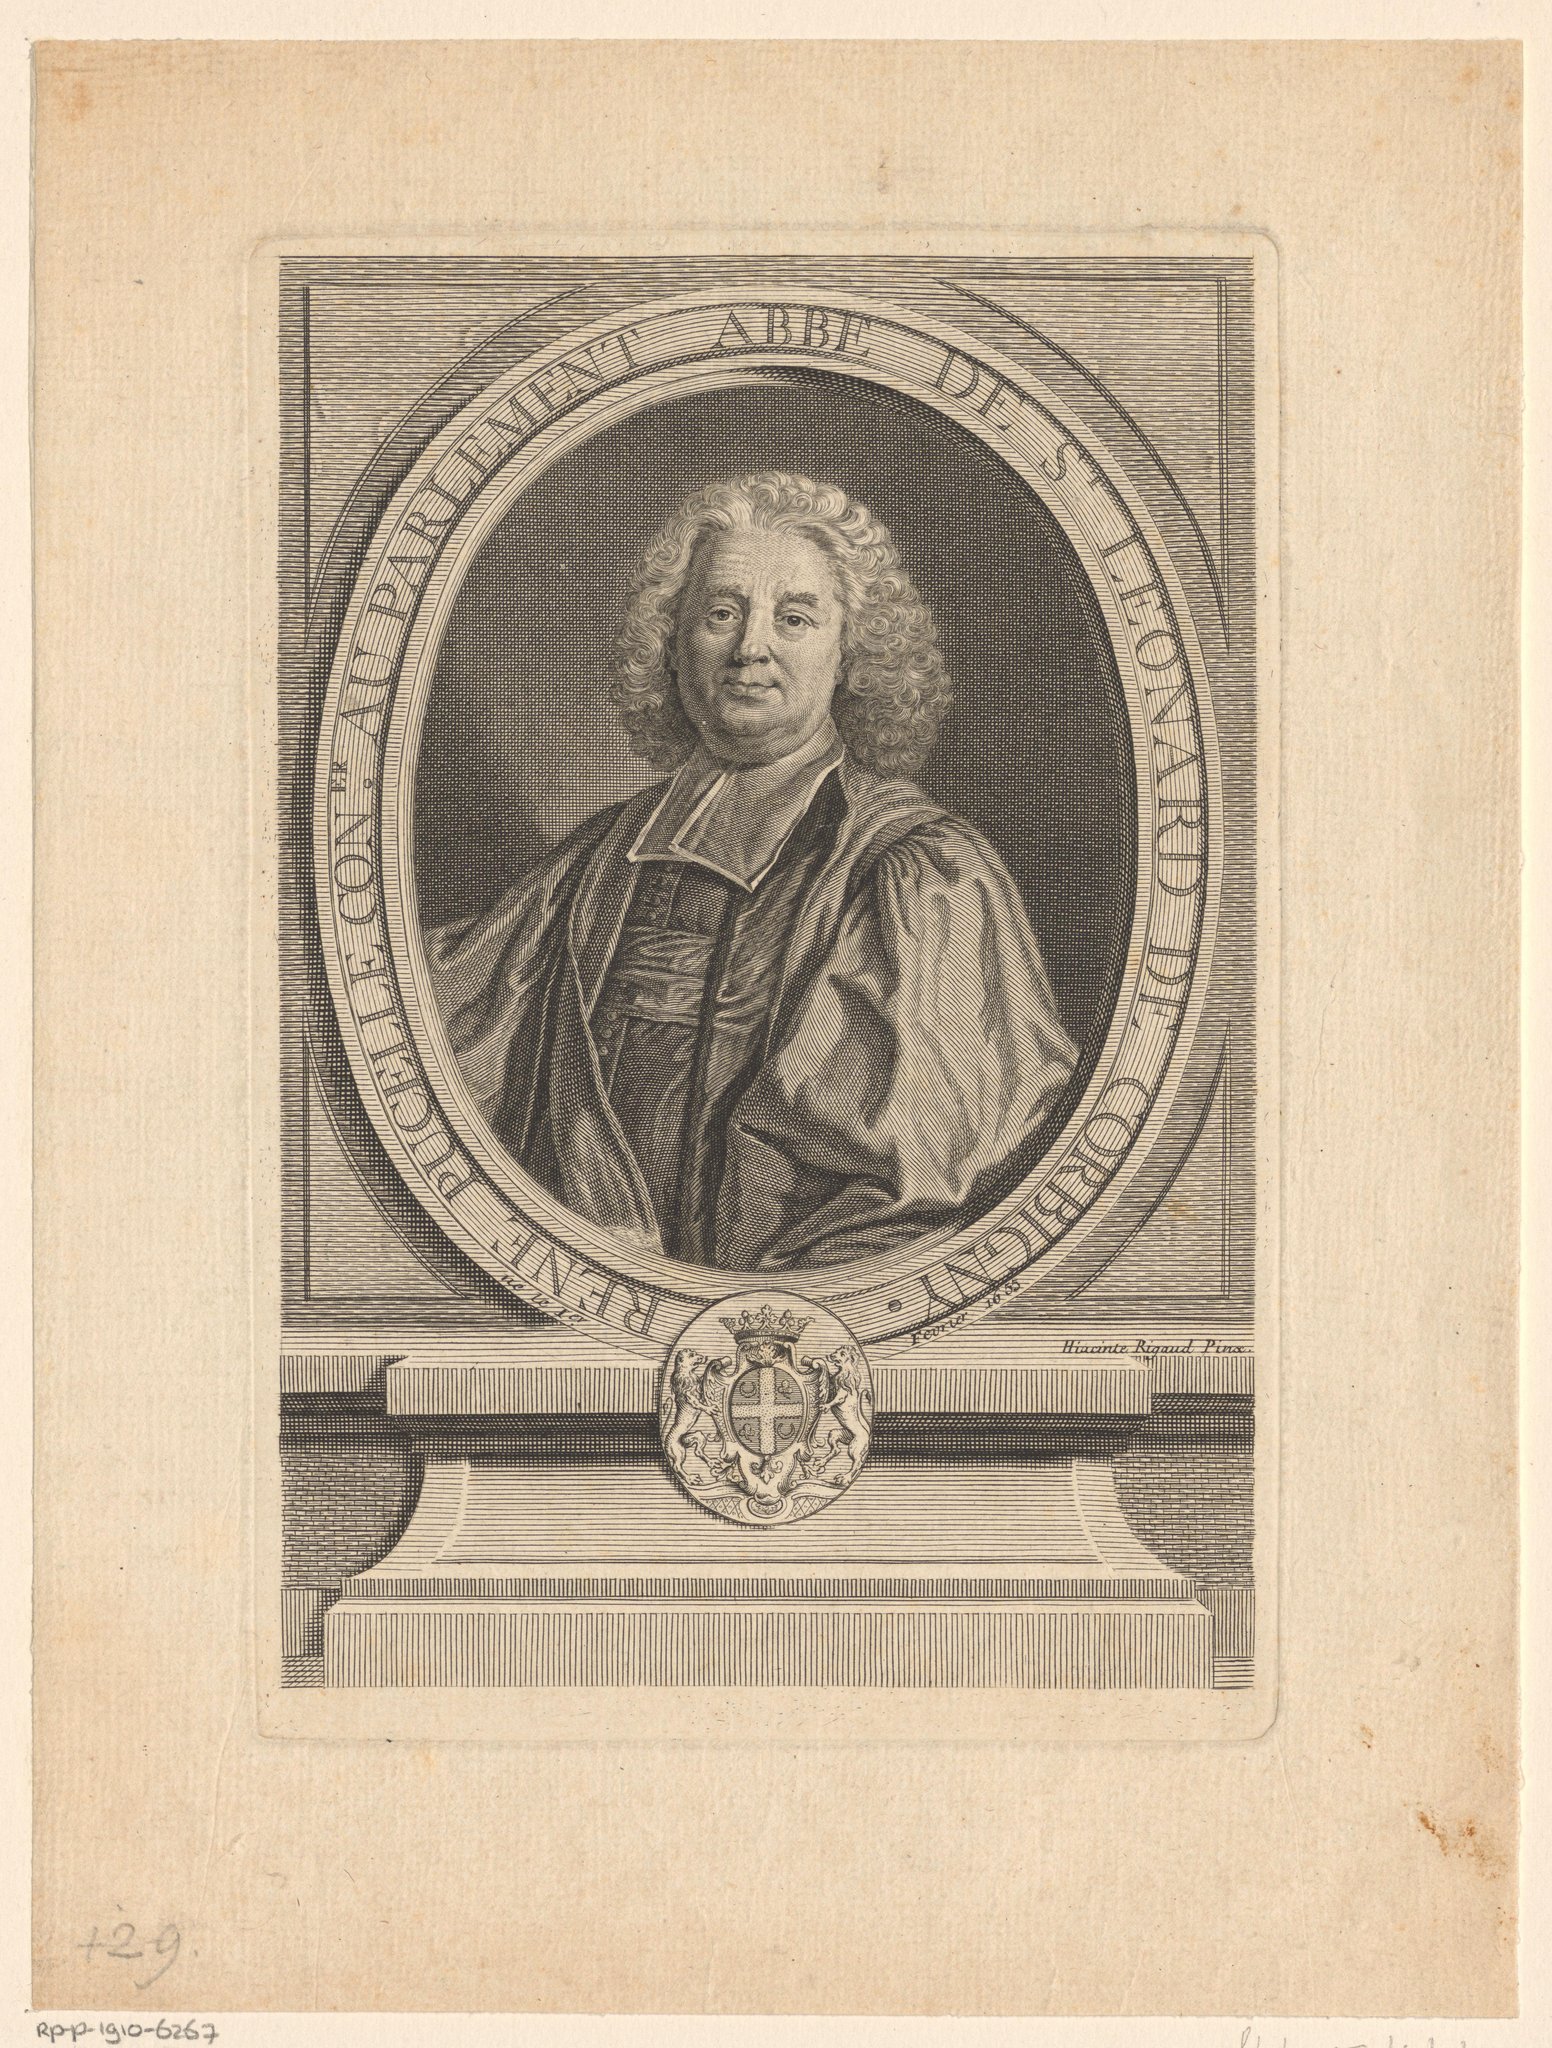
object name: print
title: Portret van René Pucelle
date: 1721-1750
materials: paper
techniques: engraving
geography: france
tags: historical persons, magistracy, judges, armorial bearing, heraldry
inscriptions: collector's mark: Lugt 2228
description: Met tekst in het Frans rondom het portret.